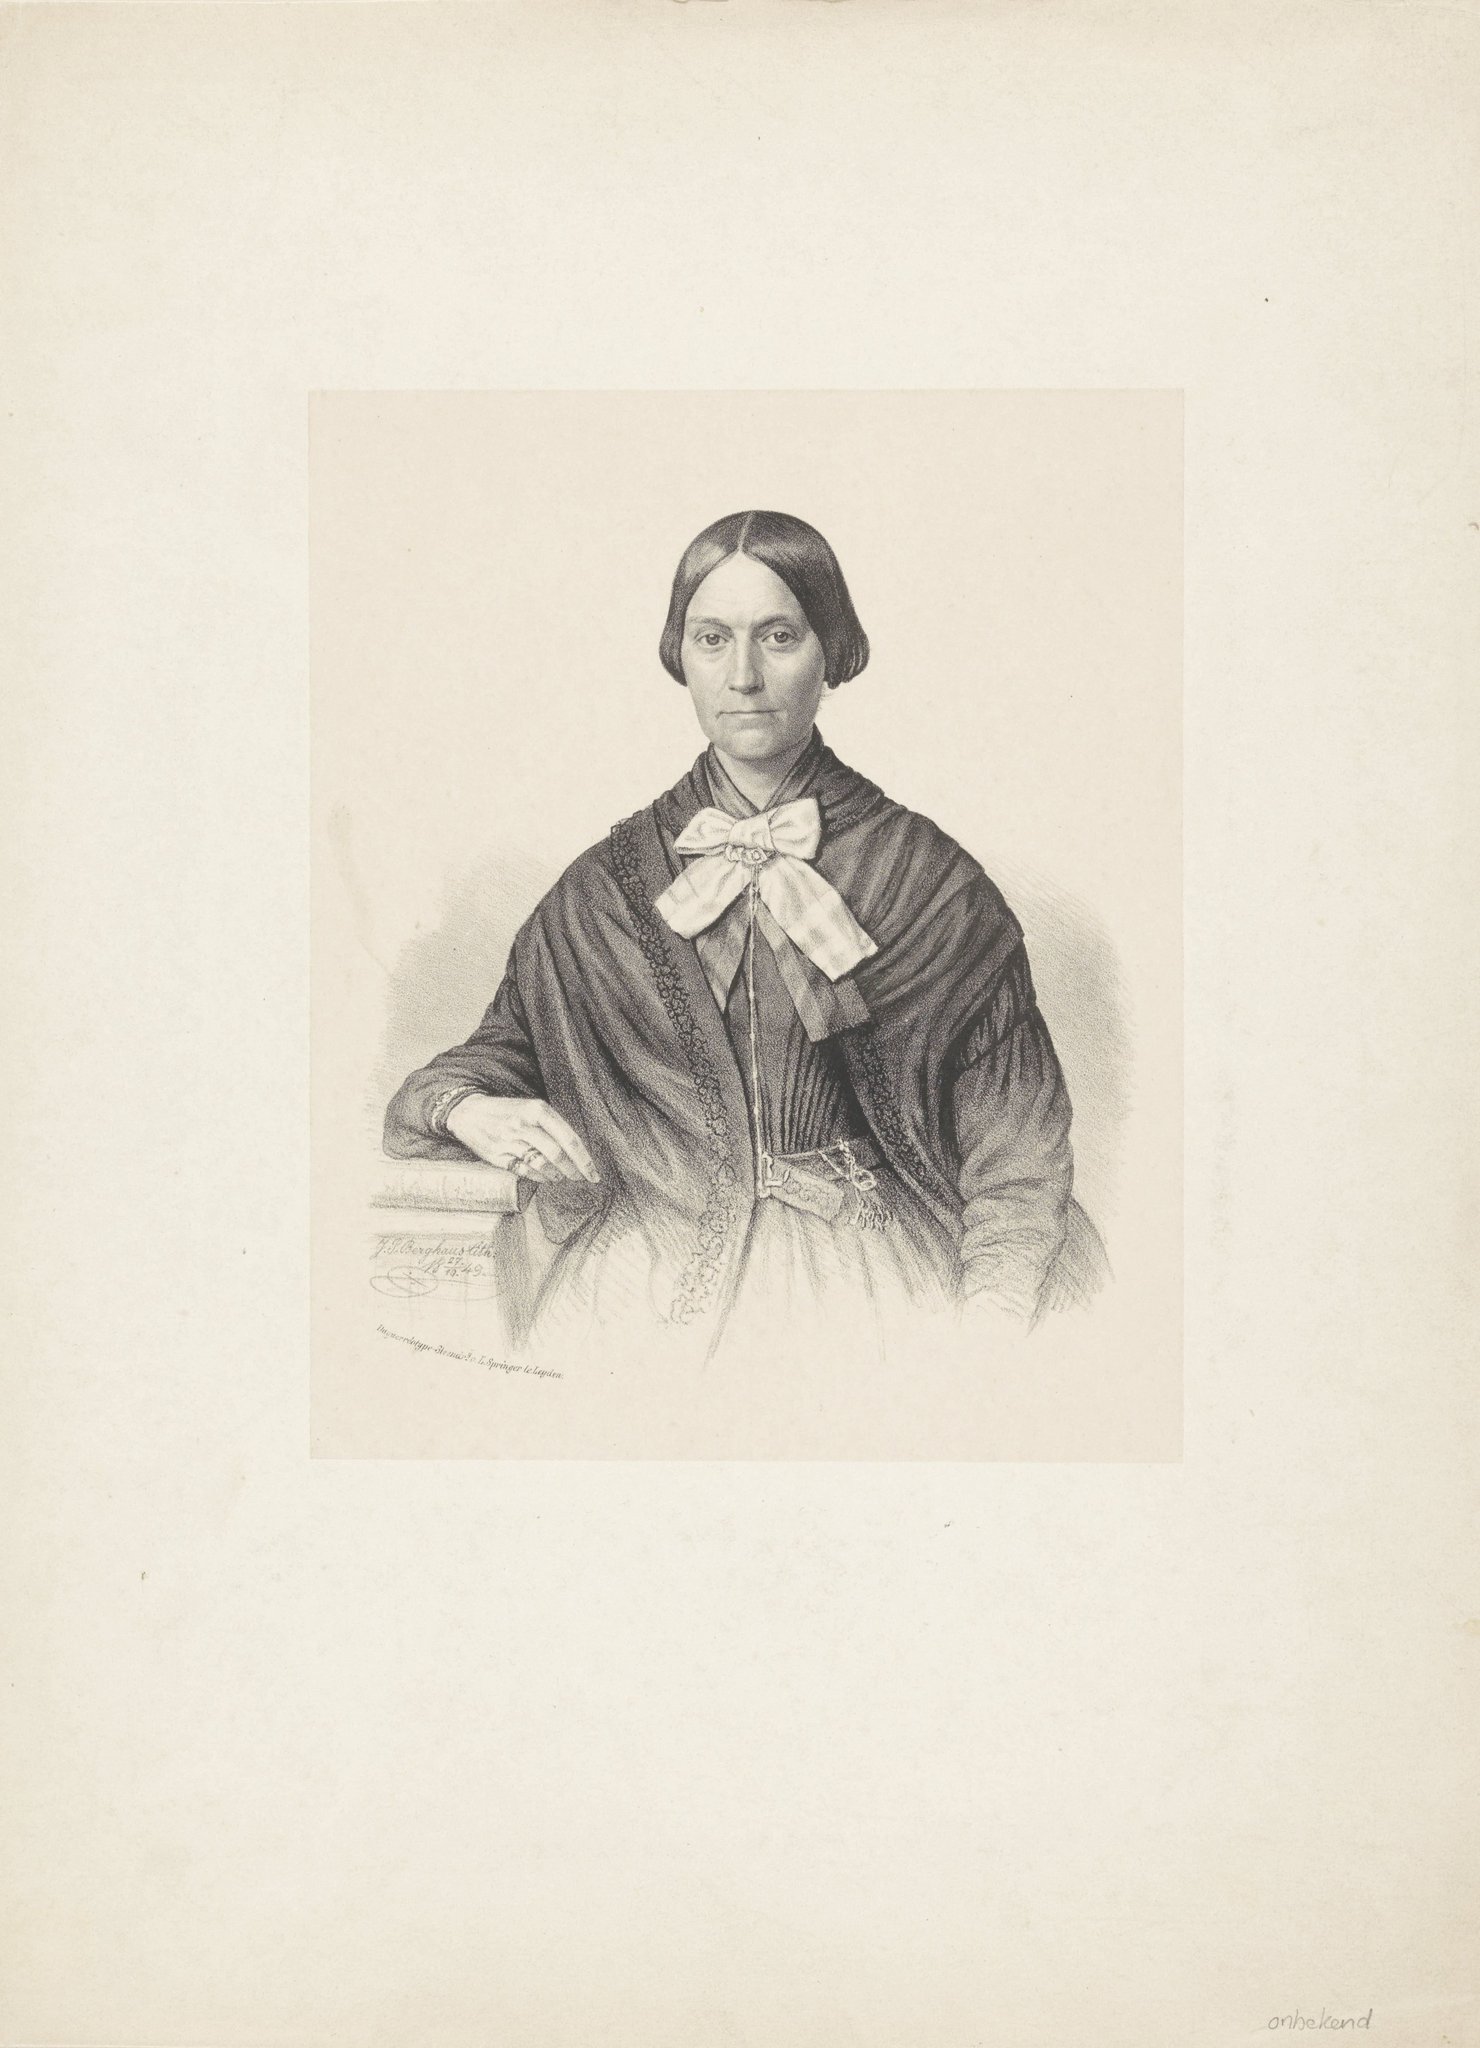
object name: print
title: Portret van een onbekende vrouw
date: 1849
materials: paper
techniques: lithograph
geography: leiden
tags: historical persons - bb - woman, key, book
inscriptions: collector's mark: Lugt 2228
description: De geportretteerde draagt haar haar in een strakke scheiding, midden op het hoofd. Zij draagt een strik en een omslagdoek. Aan de ceintuur om haar middel hangt een sleutelbos. Haar rechterarm leunt op een boek dat op tafel ligt.